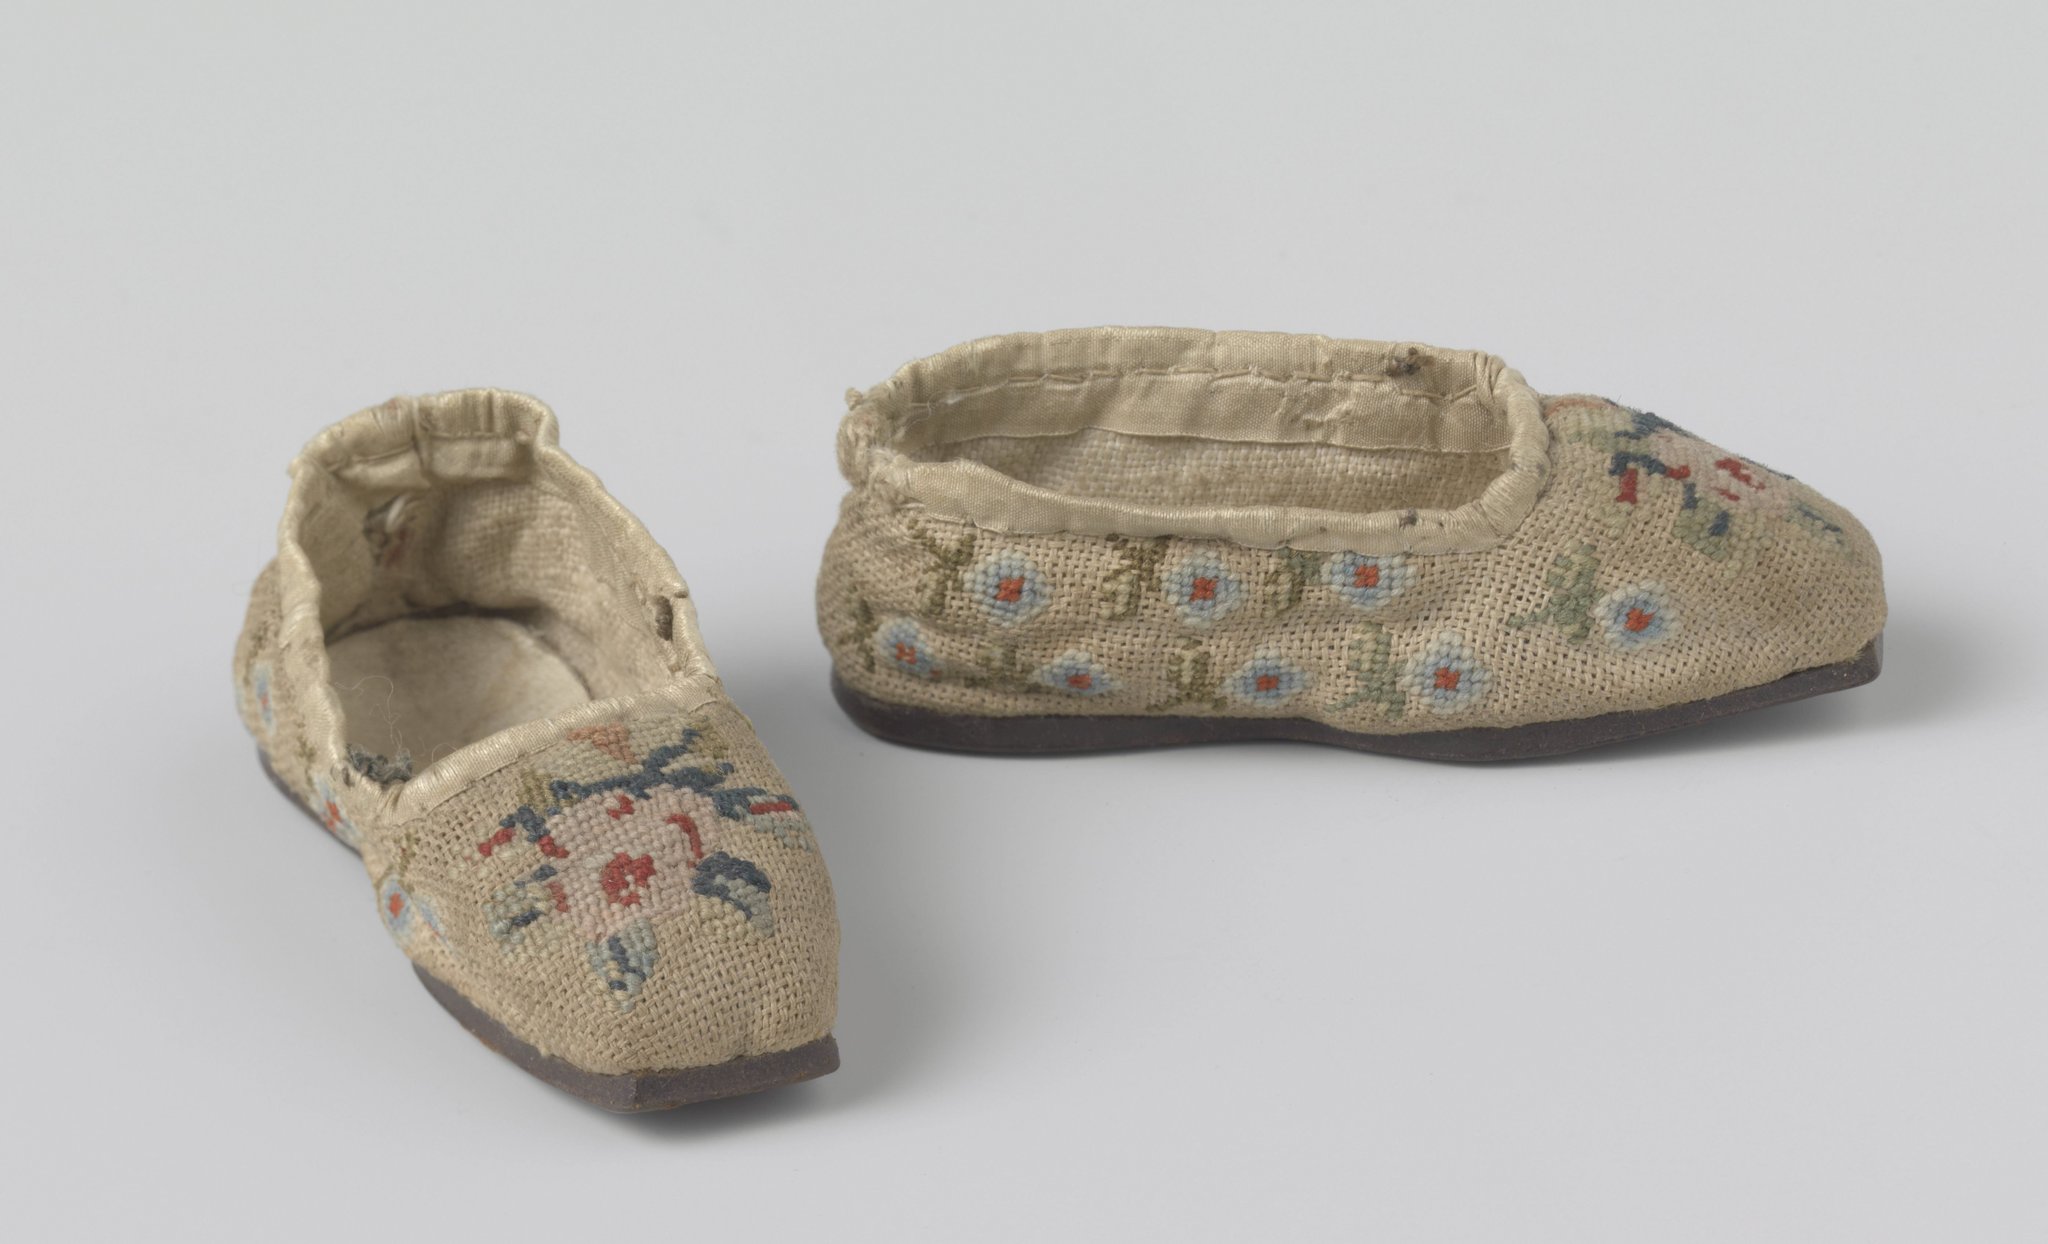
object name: doll's clothing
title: Schoen van linnen geborduurd met bloemen en takken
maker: Anonymous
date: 1825-1850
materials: leather, linen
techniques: cross stitching, embroidered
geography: netherlands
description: Poppenschoen van linnen geborduurd met bloemtakjes in blauwe kruissteek. Op het voorblad een rose roos. Geen hak, vierkante neus.